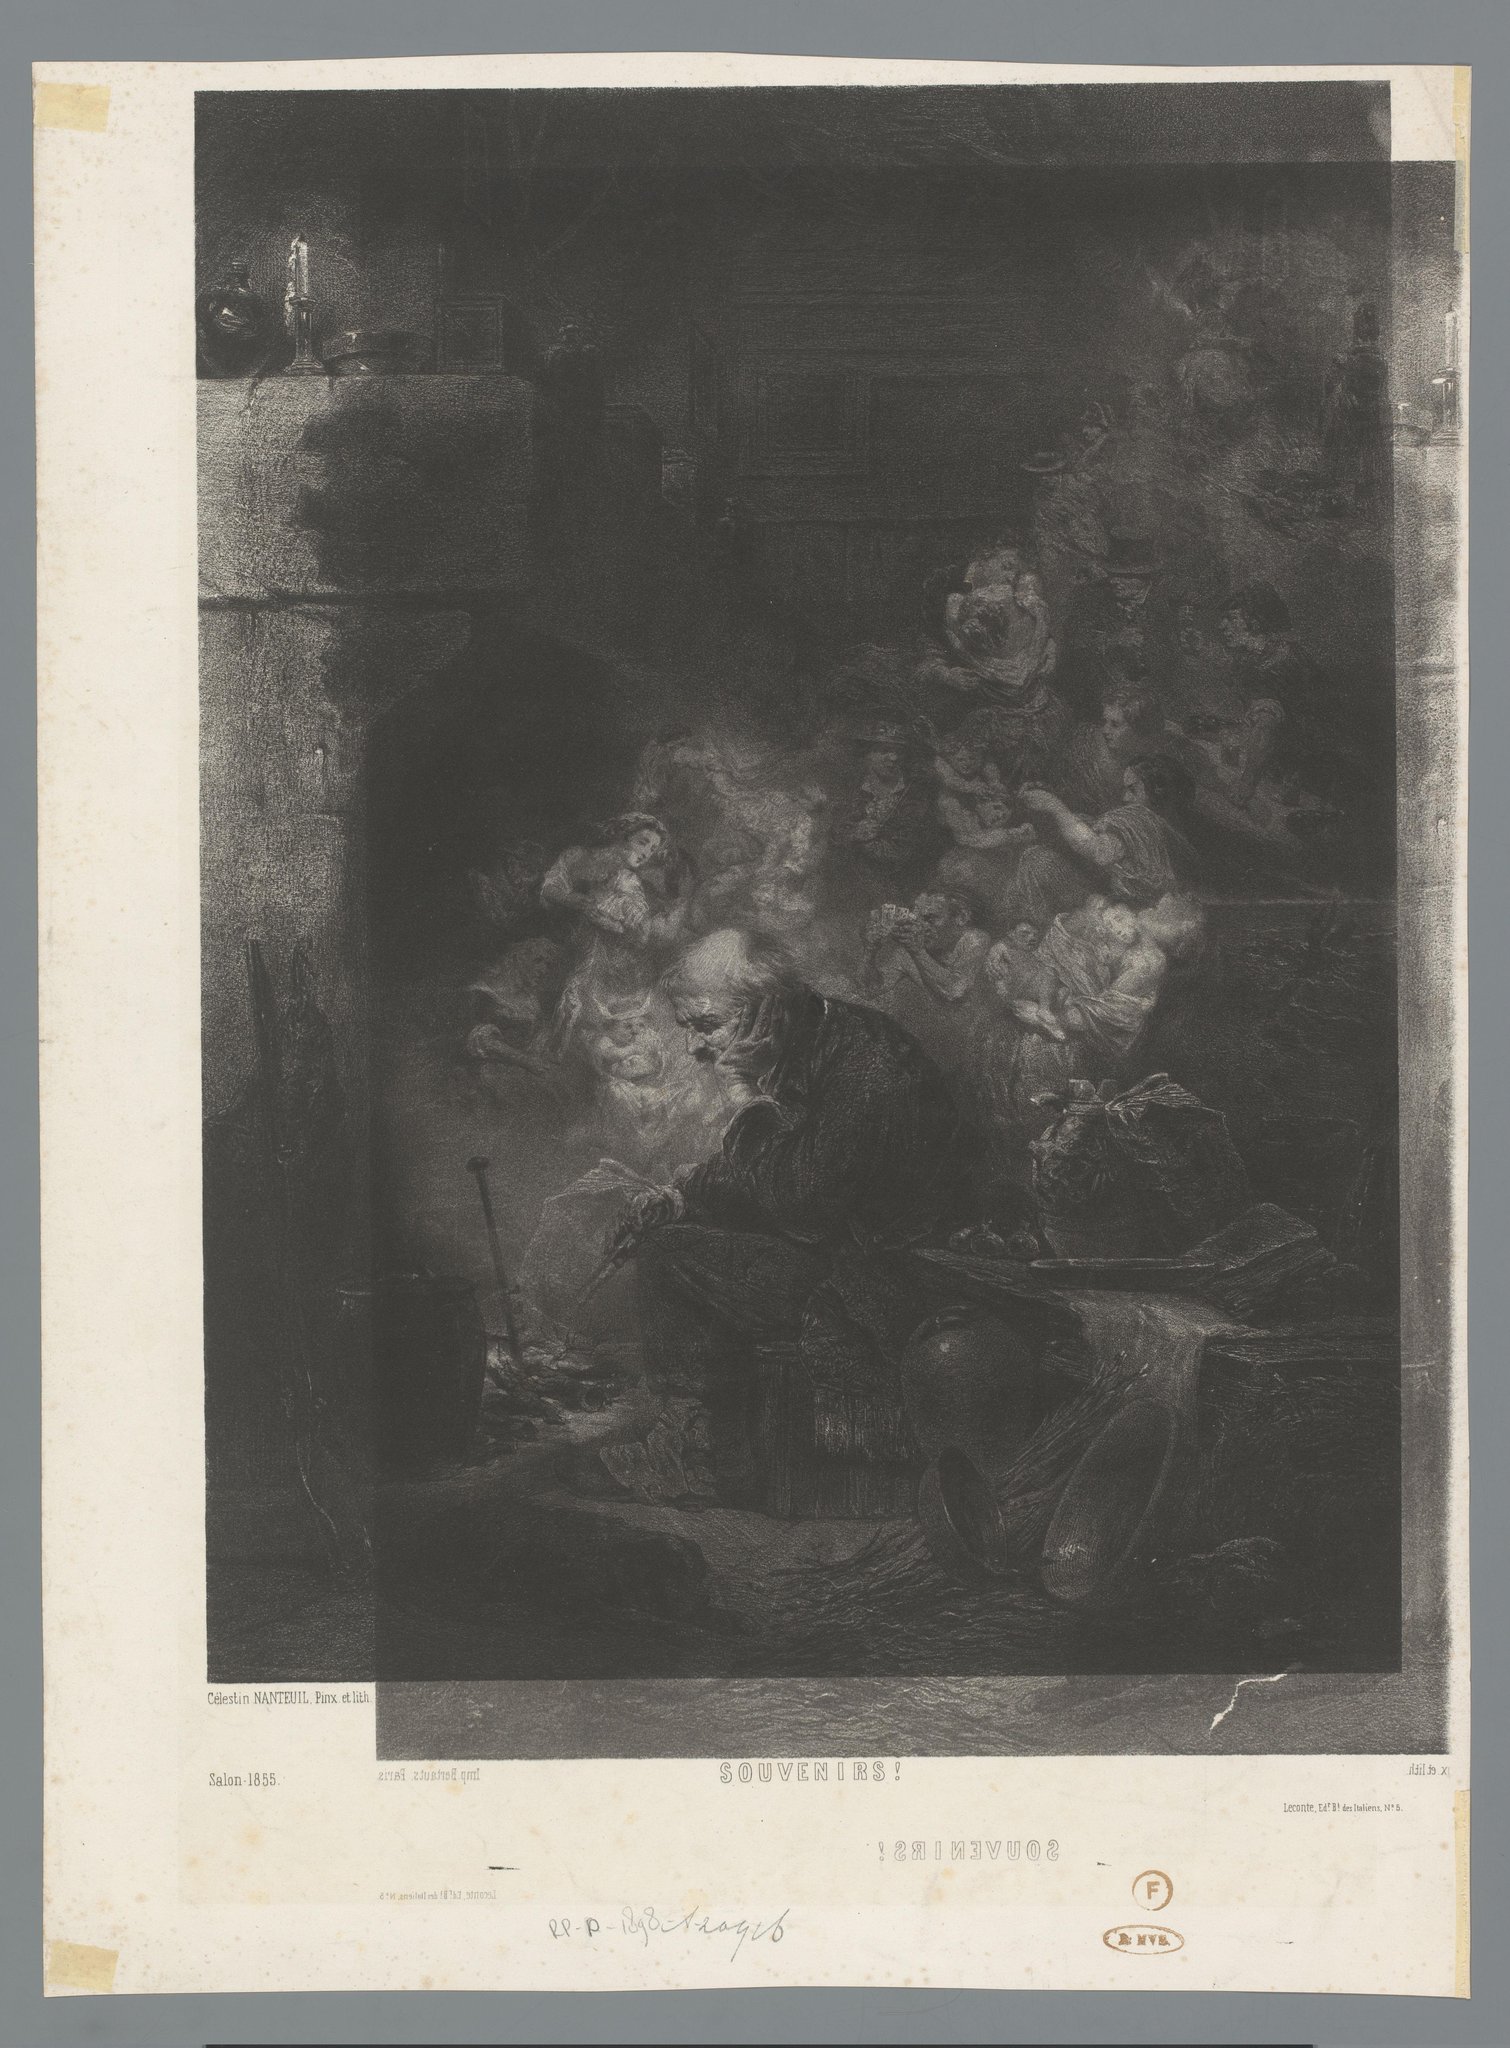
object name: print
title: Souvenirs!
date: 1855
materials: paper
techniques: printmaking, lithograph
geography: paris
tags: open hearth, fire-place, old man, drinking, cupids: 'amores', 'amoretti', 'putti'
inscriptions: collector's mark: Lugt 964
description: Schilderij waar prent naar gemaakt is, is tentoongesteld op de Salon van Parijs in 1855.